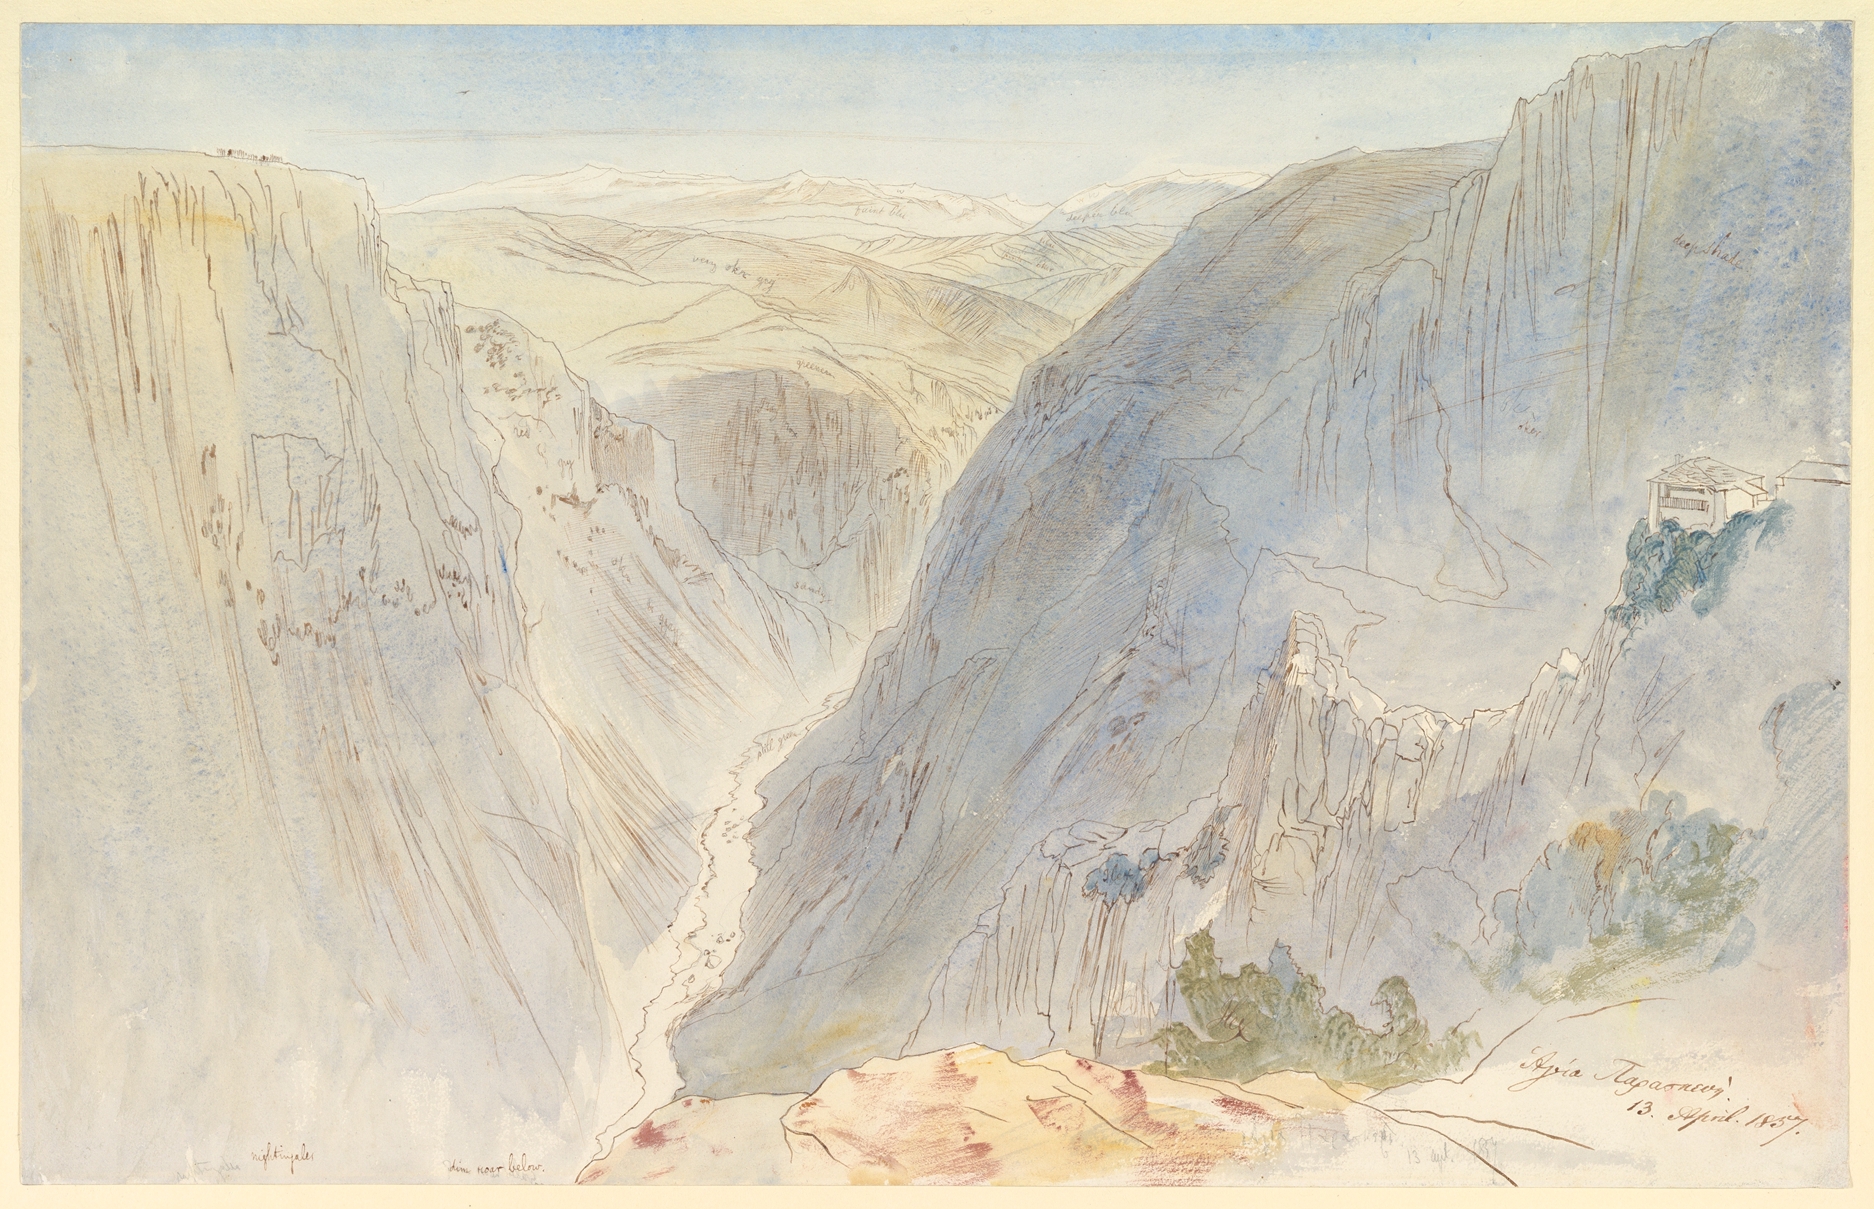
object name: drawing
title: Agia Paraskevi, Epirus, Greece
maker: edward lear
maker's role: artist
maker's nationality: british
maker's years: 1812-1888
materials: graphite, ink, watercolor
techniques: pen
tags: mountains